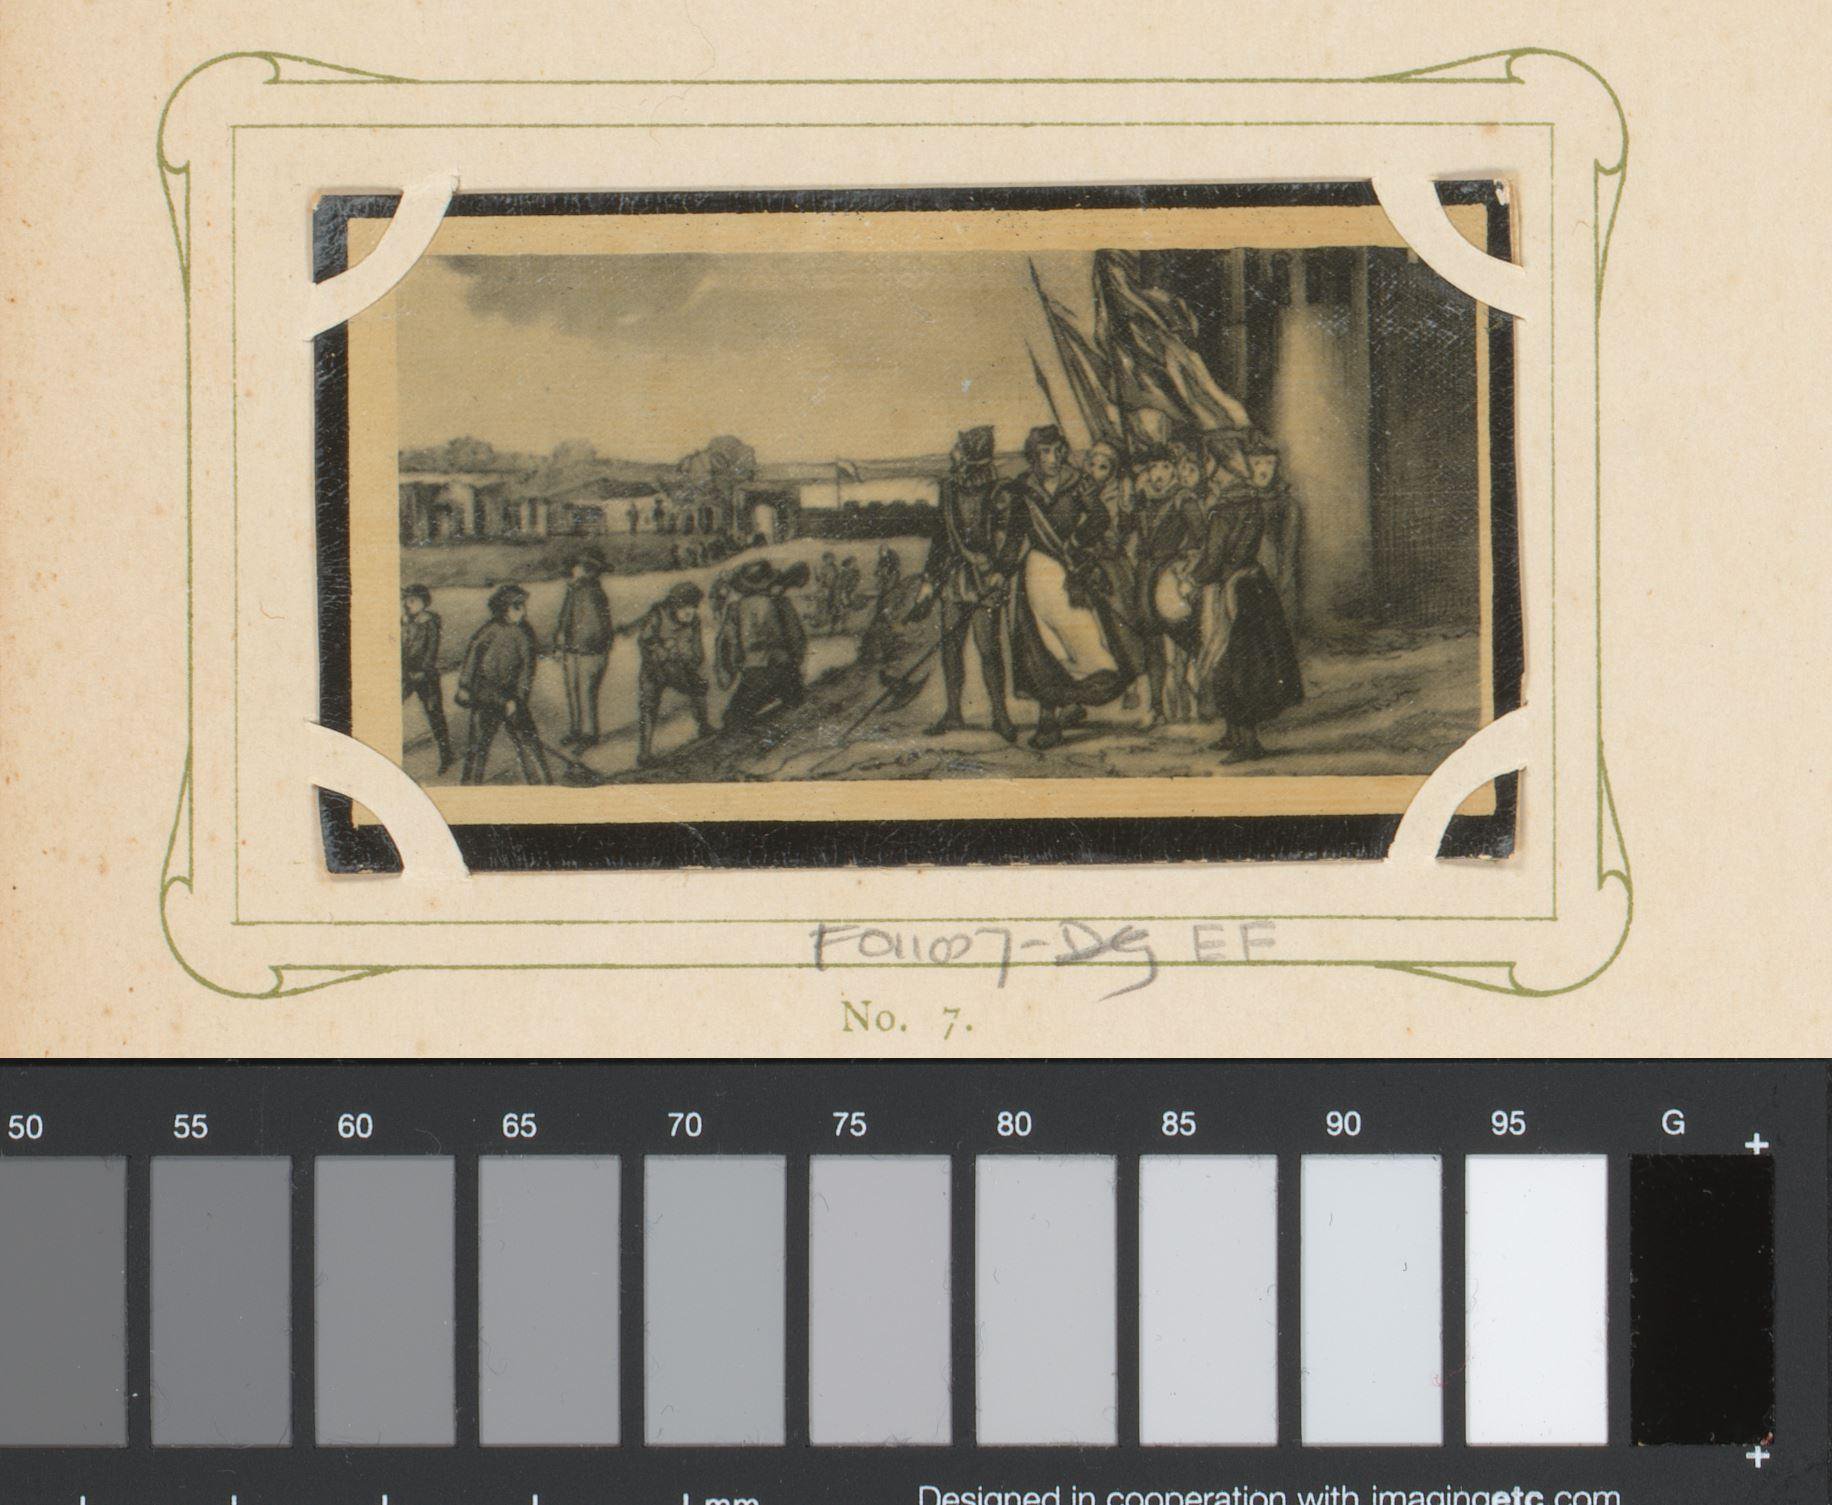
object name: album leaf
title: Reproductie van een tekening van het Beleg van Haarlem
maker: Anonymous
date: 1905-1906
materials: paper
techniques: photograph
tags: siege, haarlem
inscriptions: inscription: ‘No. 7./ Beleg van Haarlem.’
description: Deze prent maakt deel uit van een album.